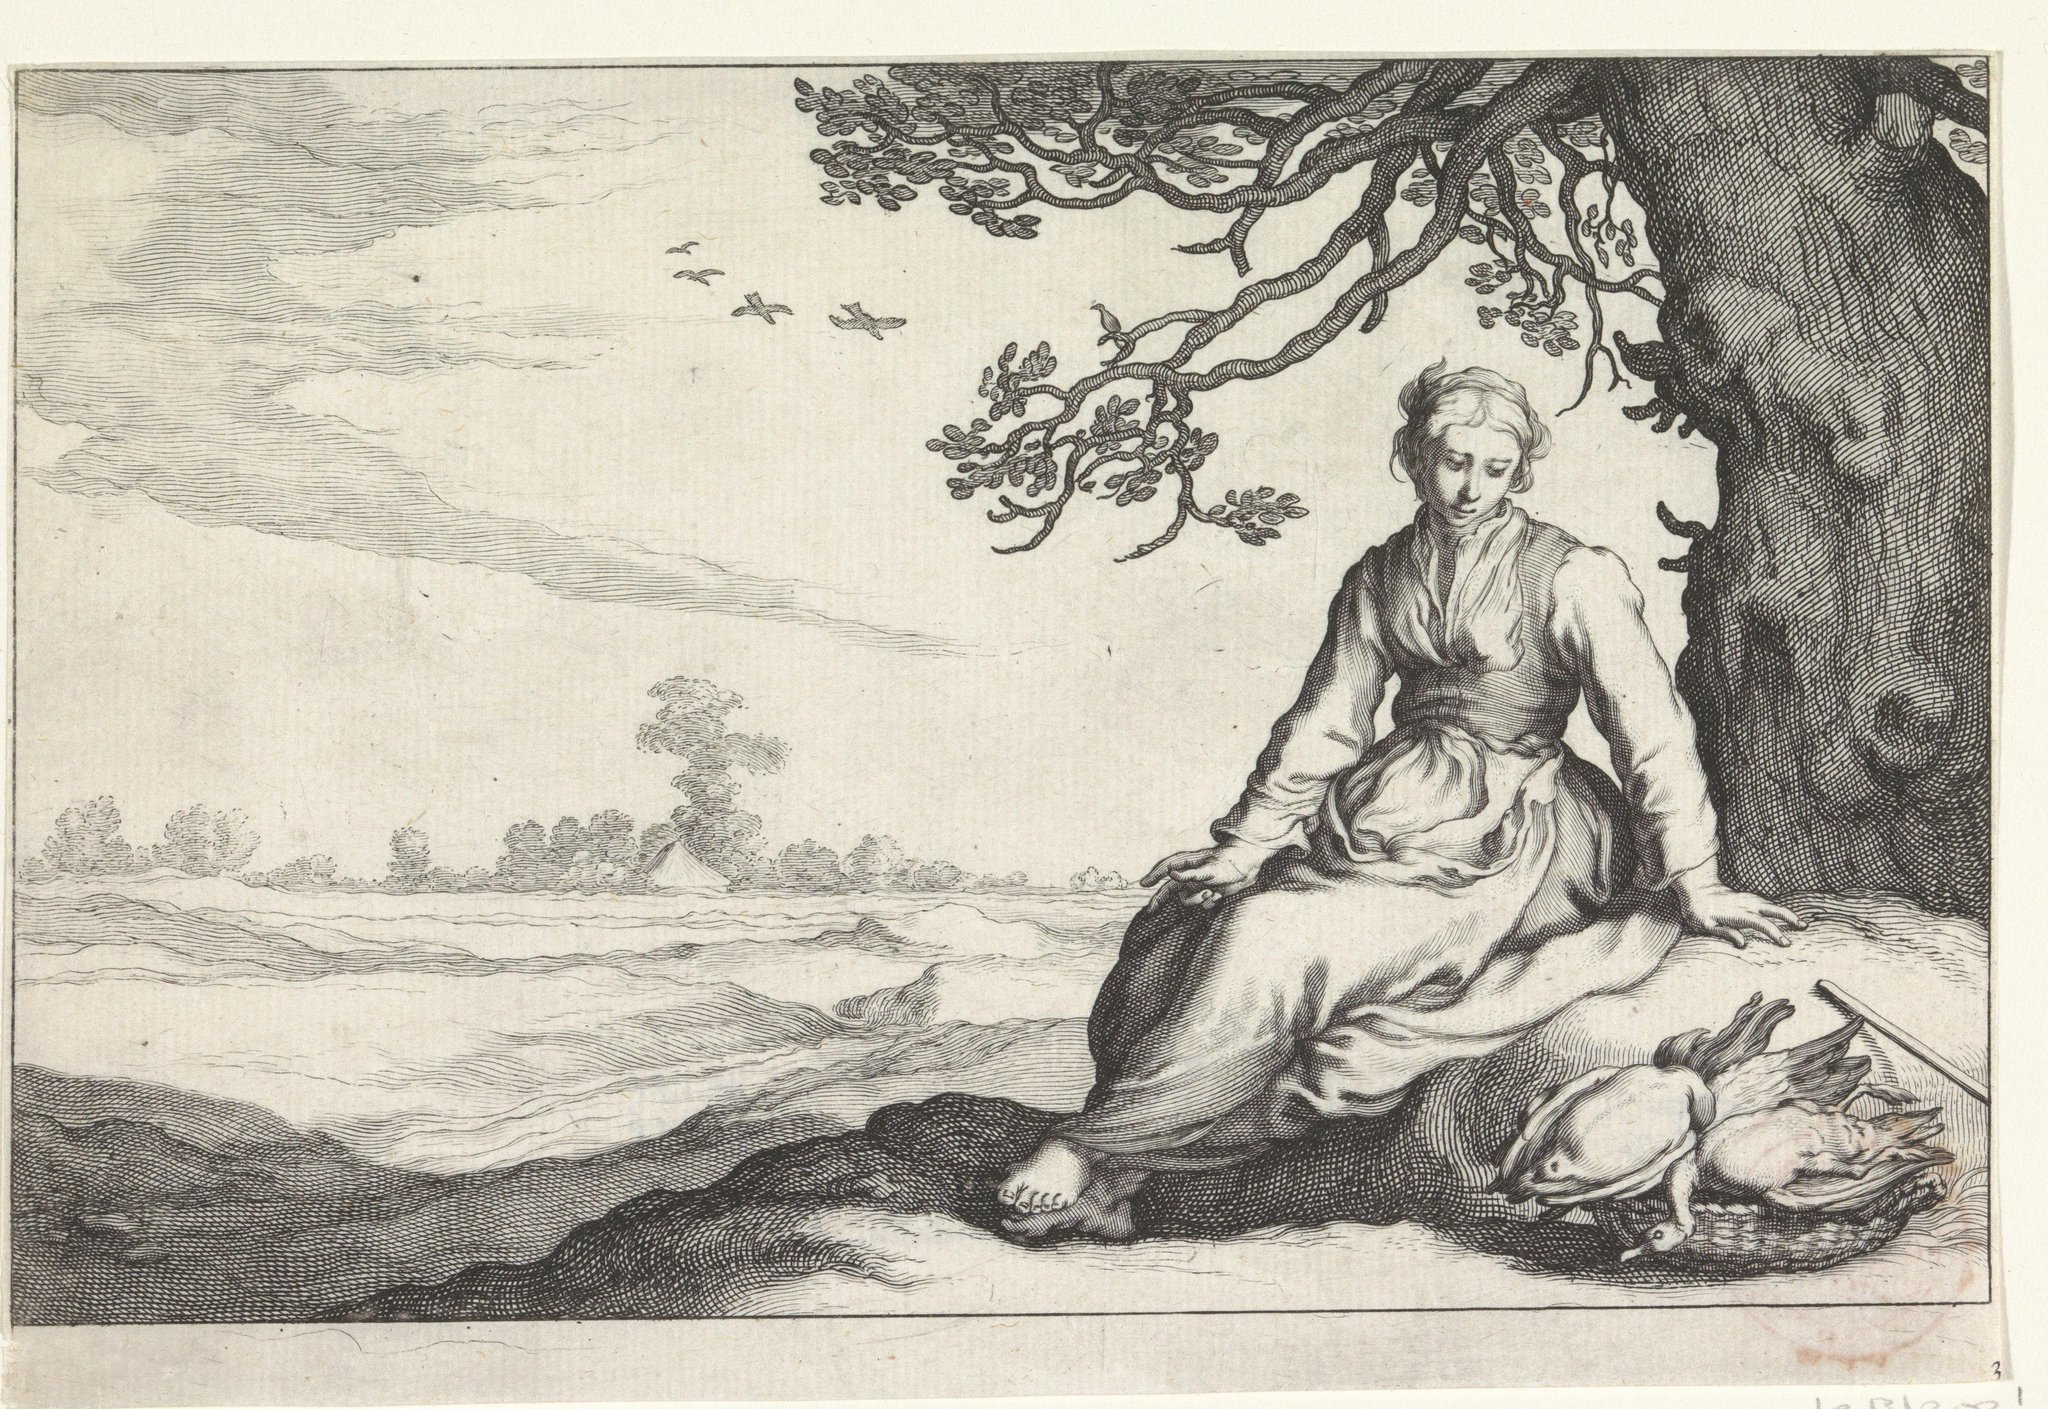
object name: print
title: Een jonge vrouw onder een boom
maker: cornelis bloemaert (ii)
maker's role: draughtsman, print maker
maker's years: 1603-1692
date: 1650-1716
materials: paper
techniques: engraving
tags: pastorals, arcadian scenes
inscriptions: collector's mark: Lugt 240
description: Een vrouw rust uit onder een boom in een landelijke omgeving. Naast haar twee ganzen.